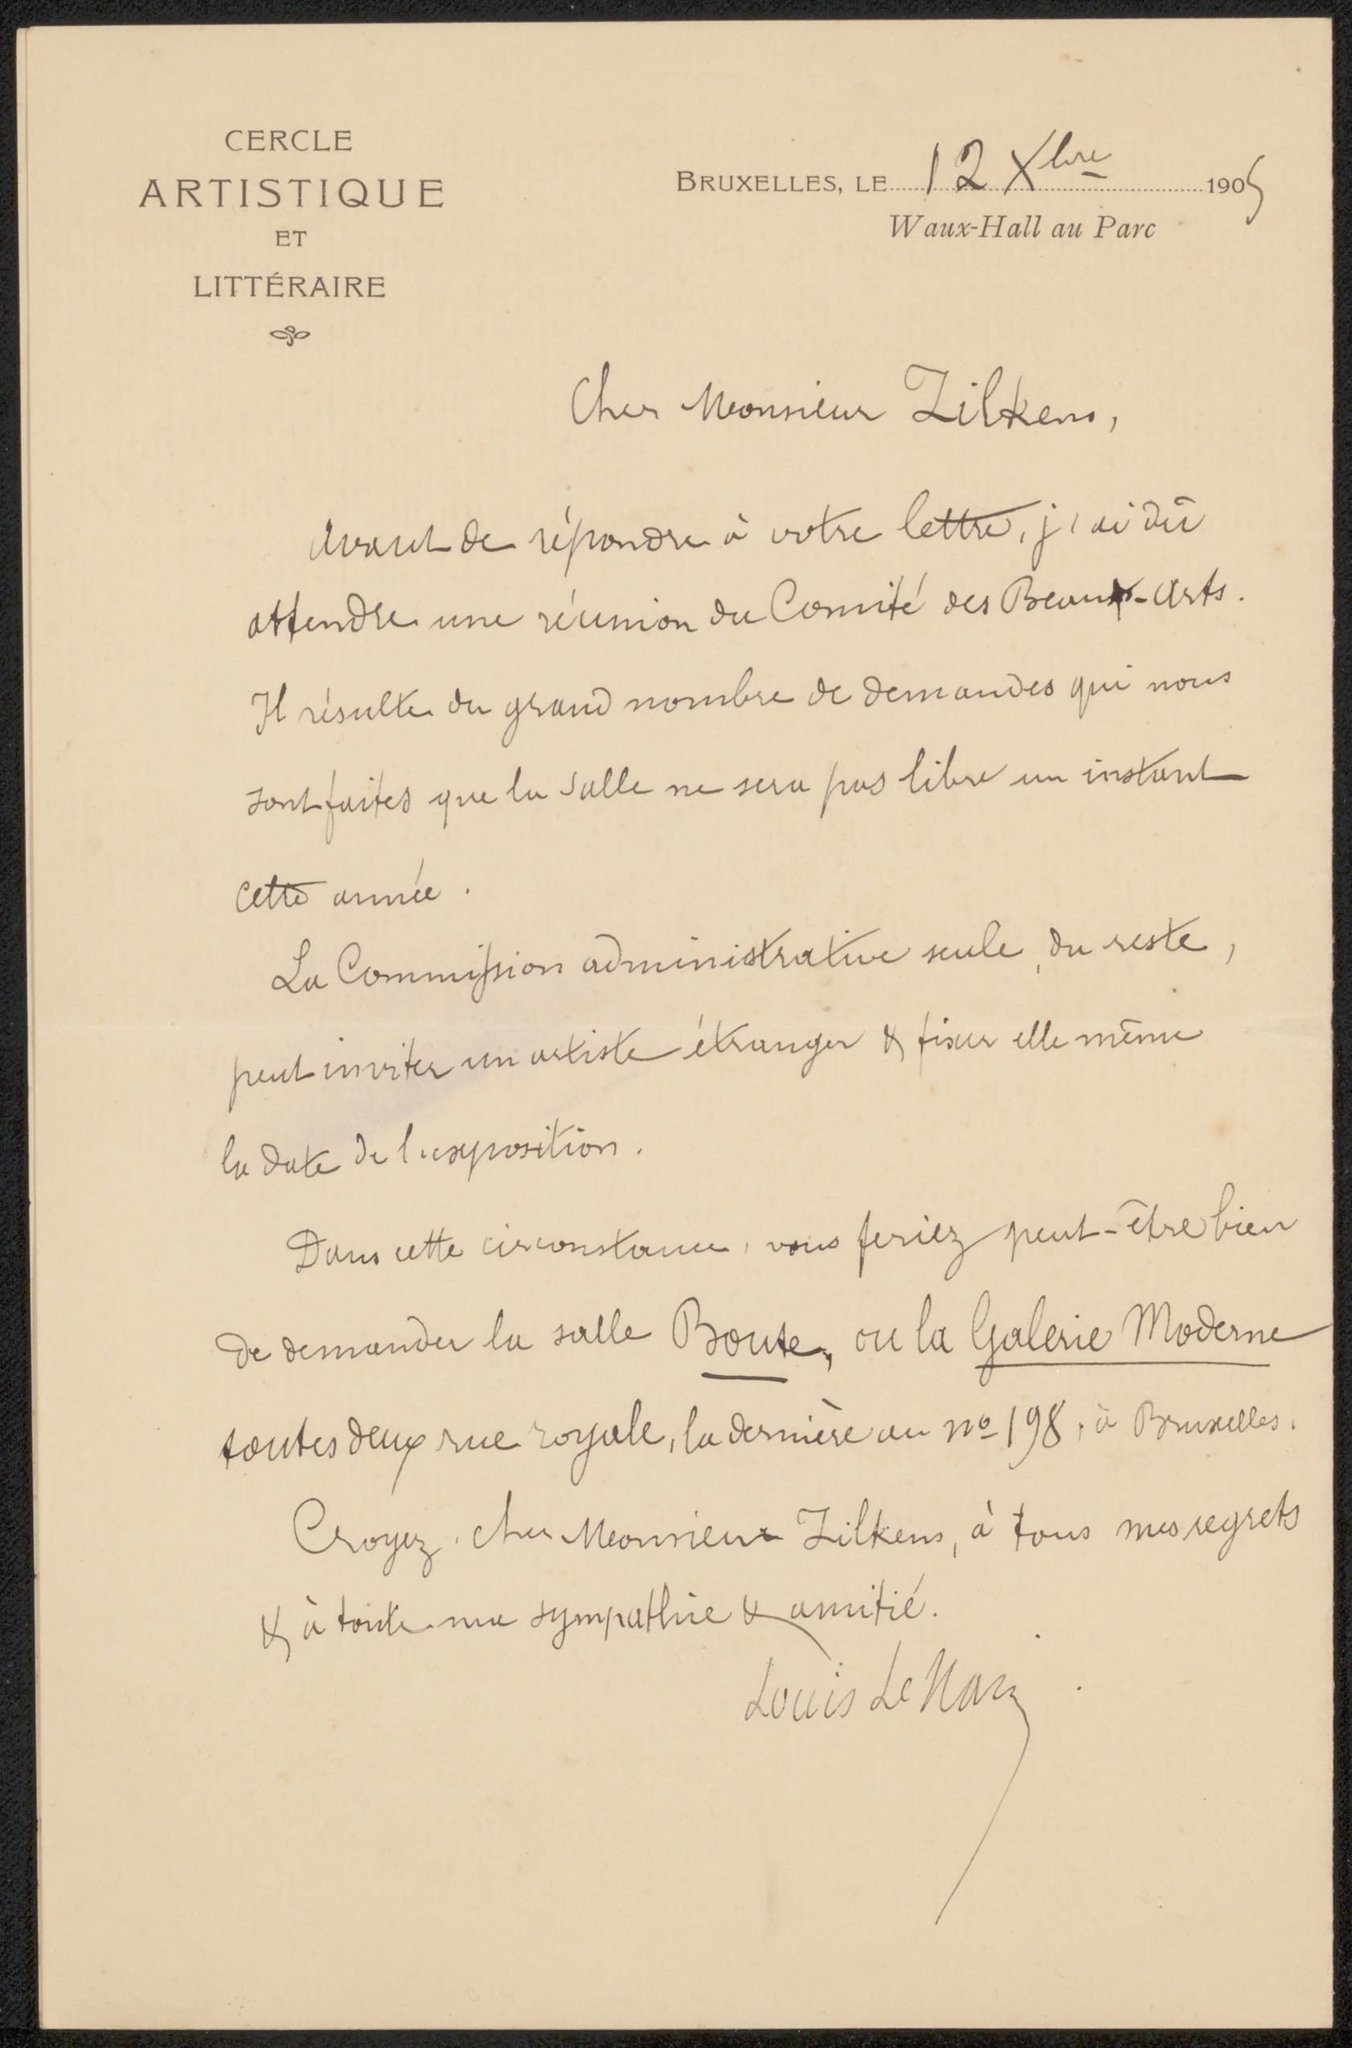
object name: letter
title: Brief aan Philip Zilcken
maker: louis le nain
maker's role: print maker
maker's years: 1851-1939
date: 1905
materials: ink, paper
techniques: pen, printing, writing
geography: brussels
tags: the hague, painter, draughtsman, philip zilcken, exhibition ~ art, brussels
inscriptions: collector's mark: ‘RPK’, watermark